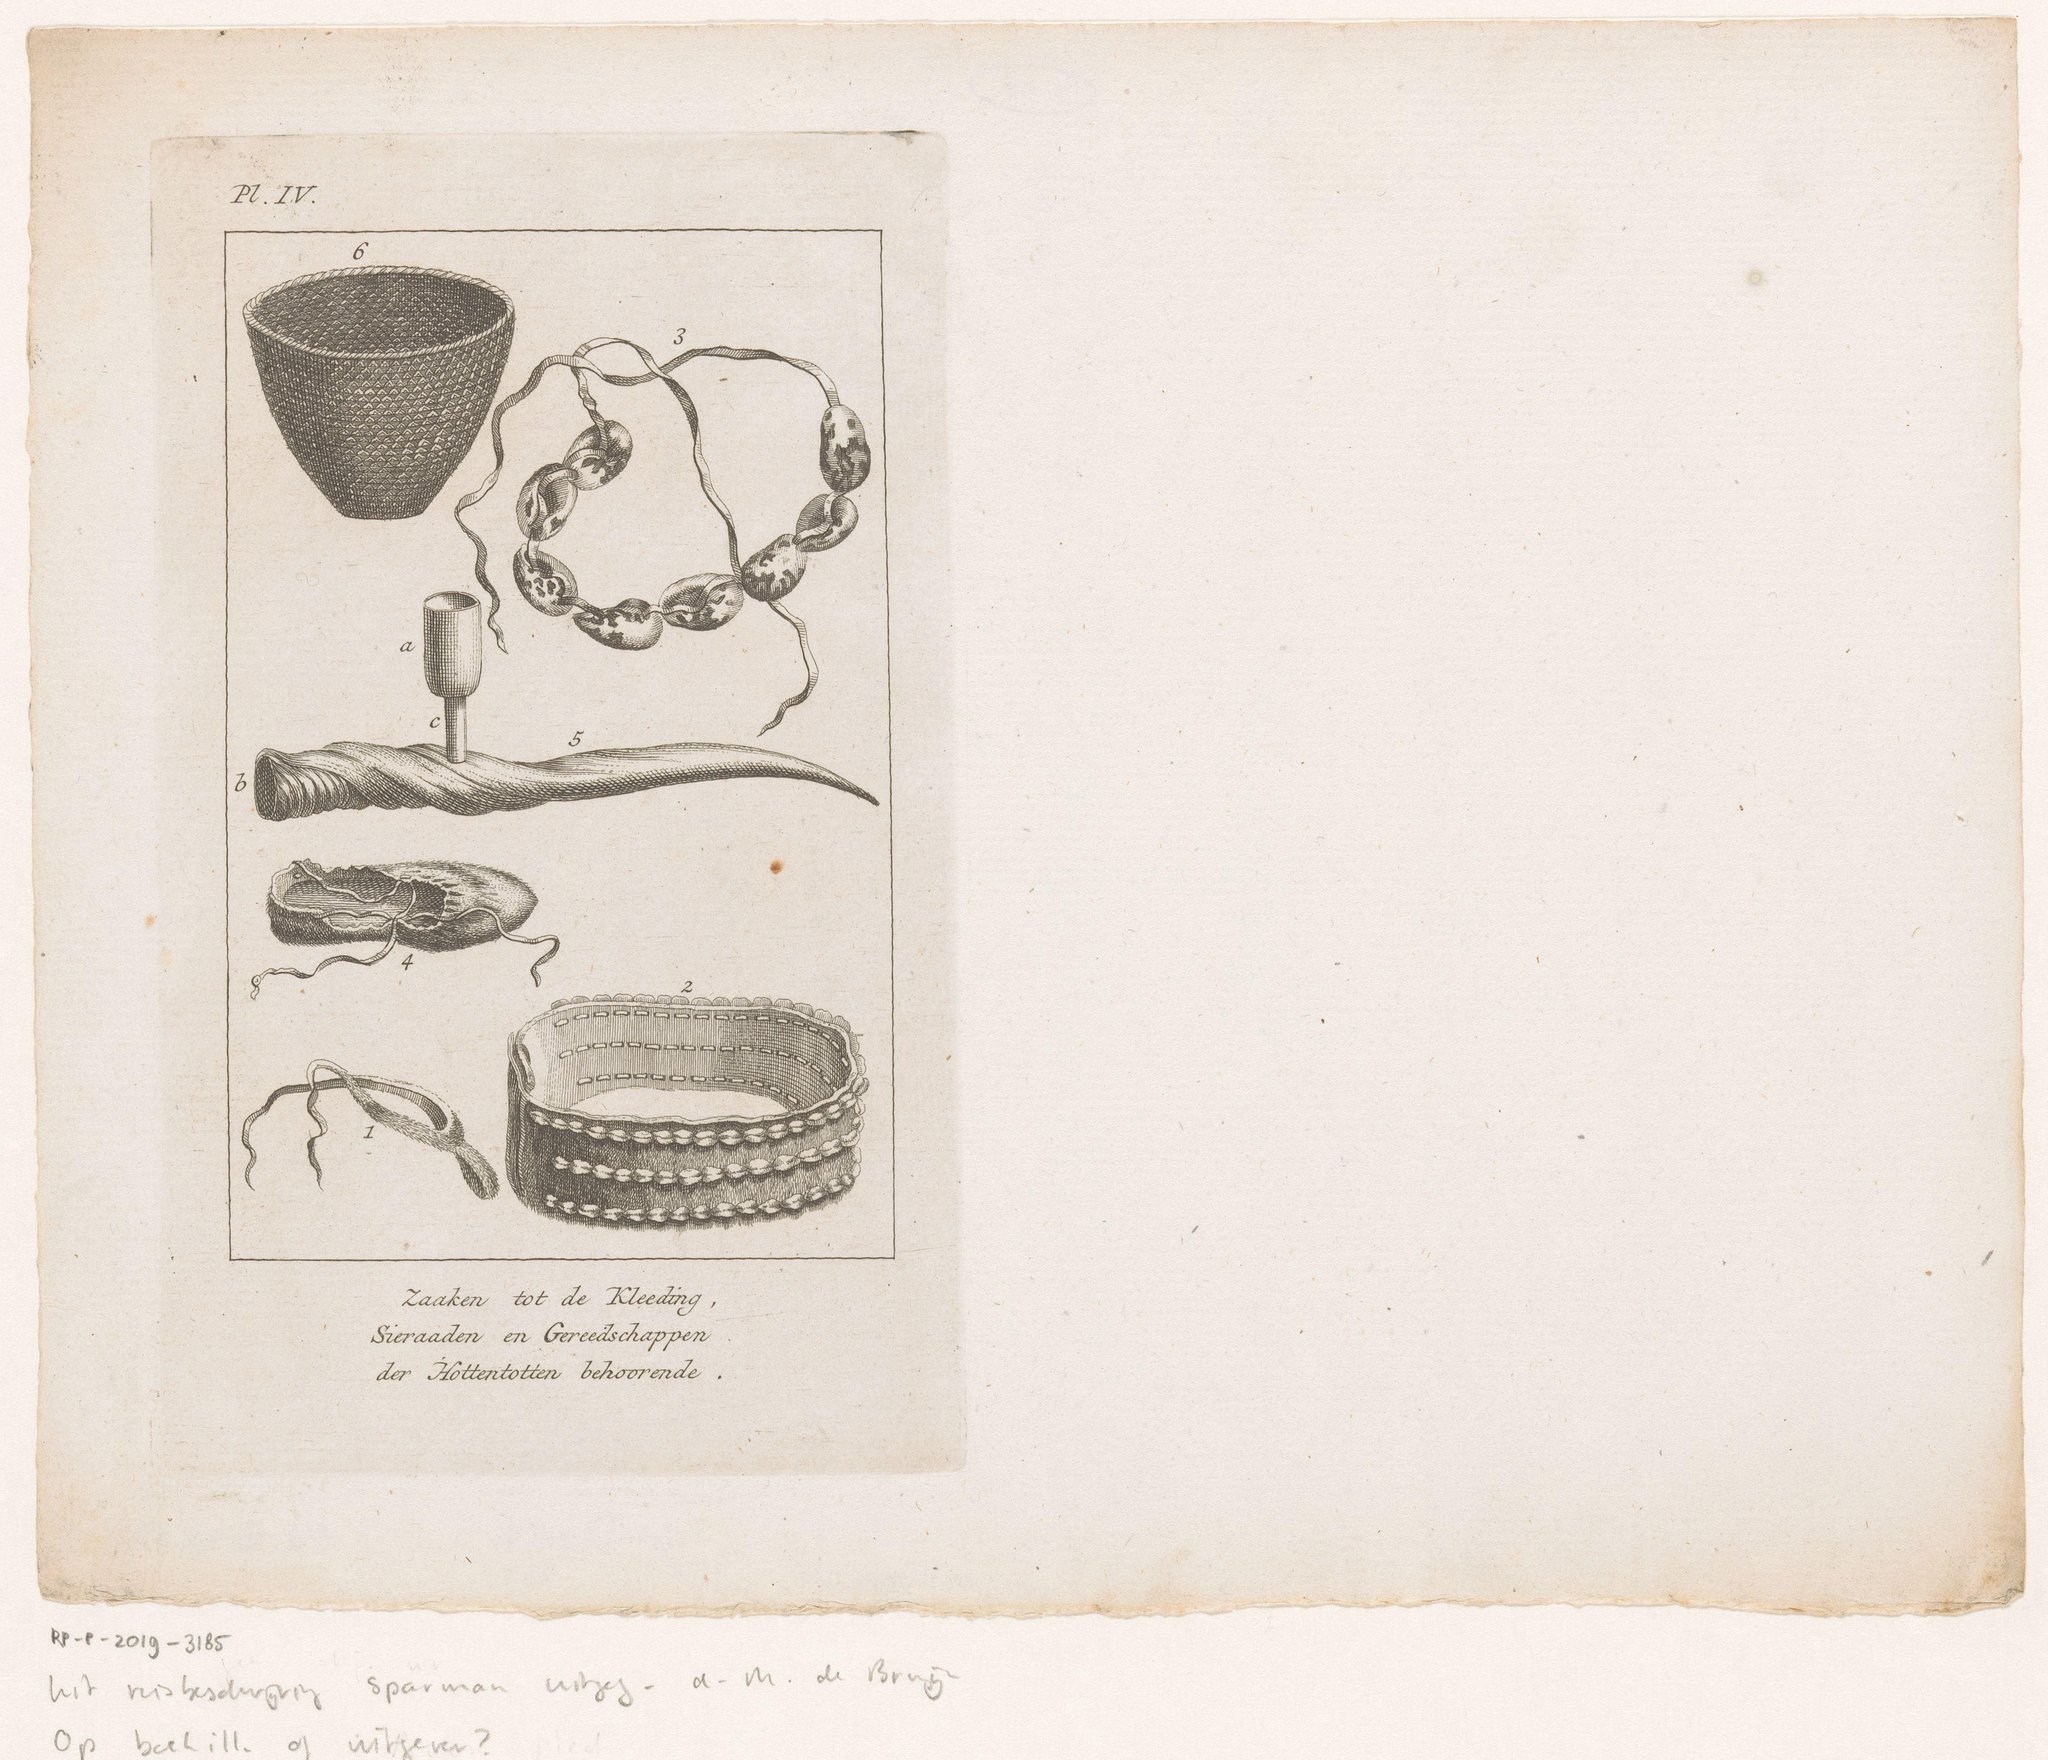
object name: book illustration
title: Gereedschap, kleding en sieraden van de Khoikhoi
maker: Anonymous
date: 1787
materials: paper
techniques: etching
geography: netherlands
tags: ornaments, jewels, khoikhoi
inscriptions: watermark, collector's mark: Lugt 2228